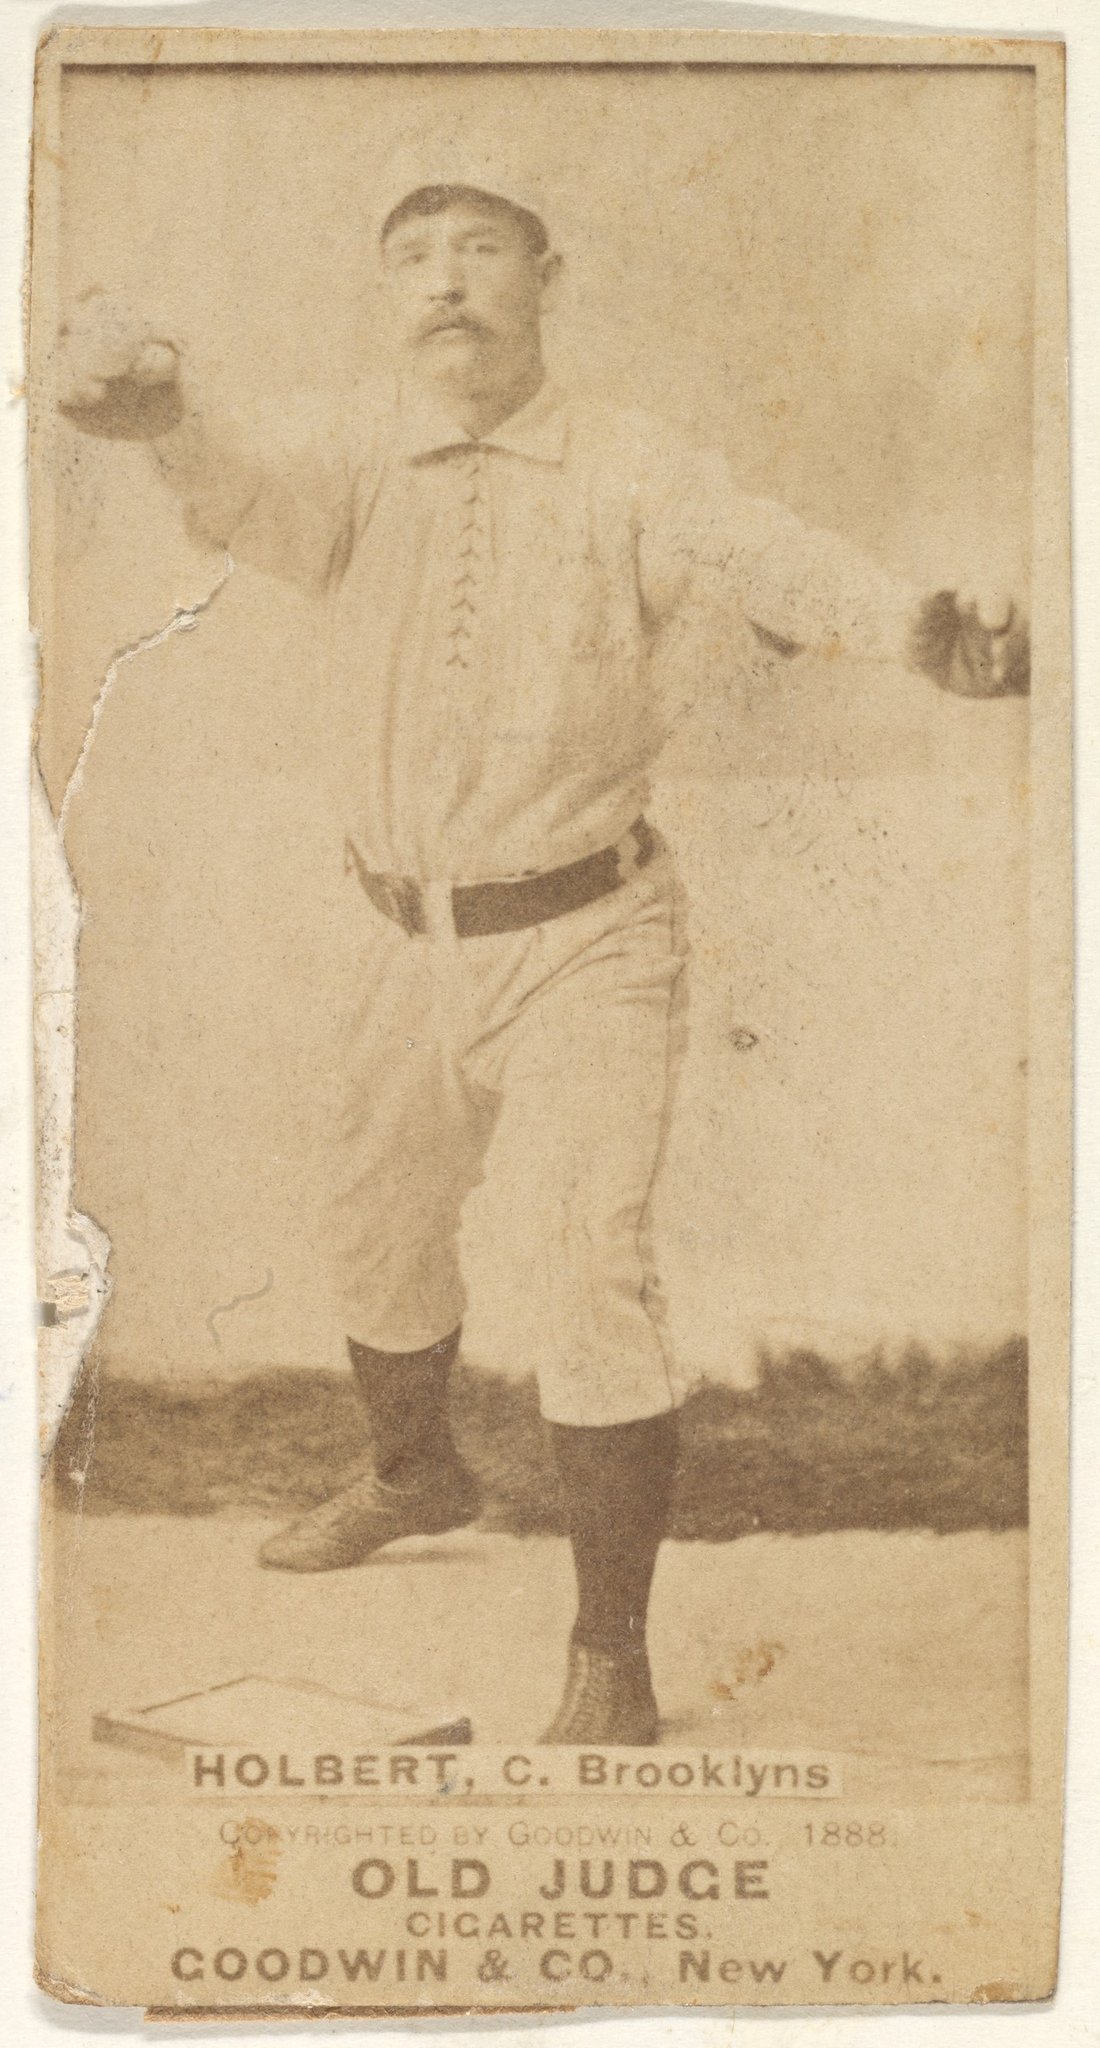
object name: baseball card, photograph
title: Holbert, Catcher, Brooklyn Bridegrooms, from the Old Judge series (N172) for Old Judge Cigarettes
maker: goodwin & company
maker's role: publisher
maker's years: 1850-1950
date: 1888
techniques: albumen silver print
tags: men,portraits,baseball,athletes